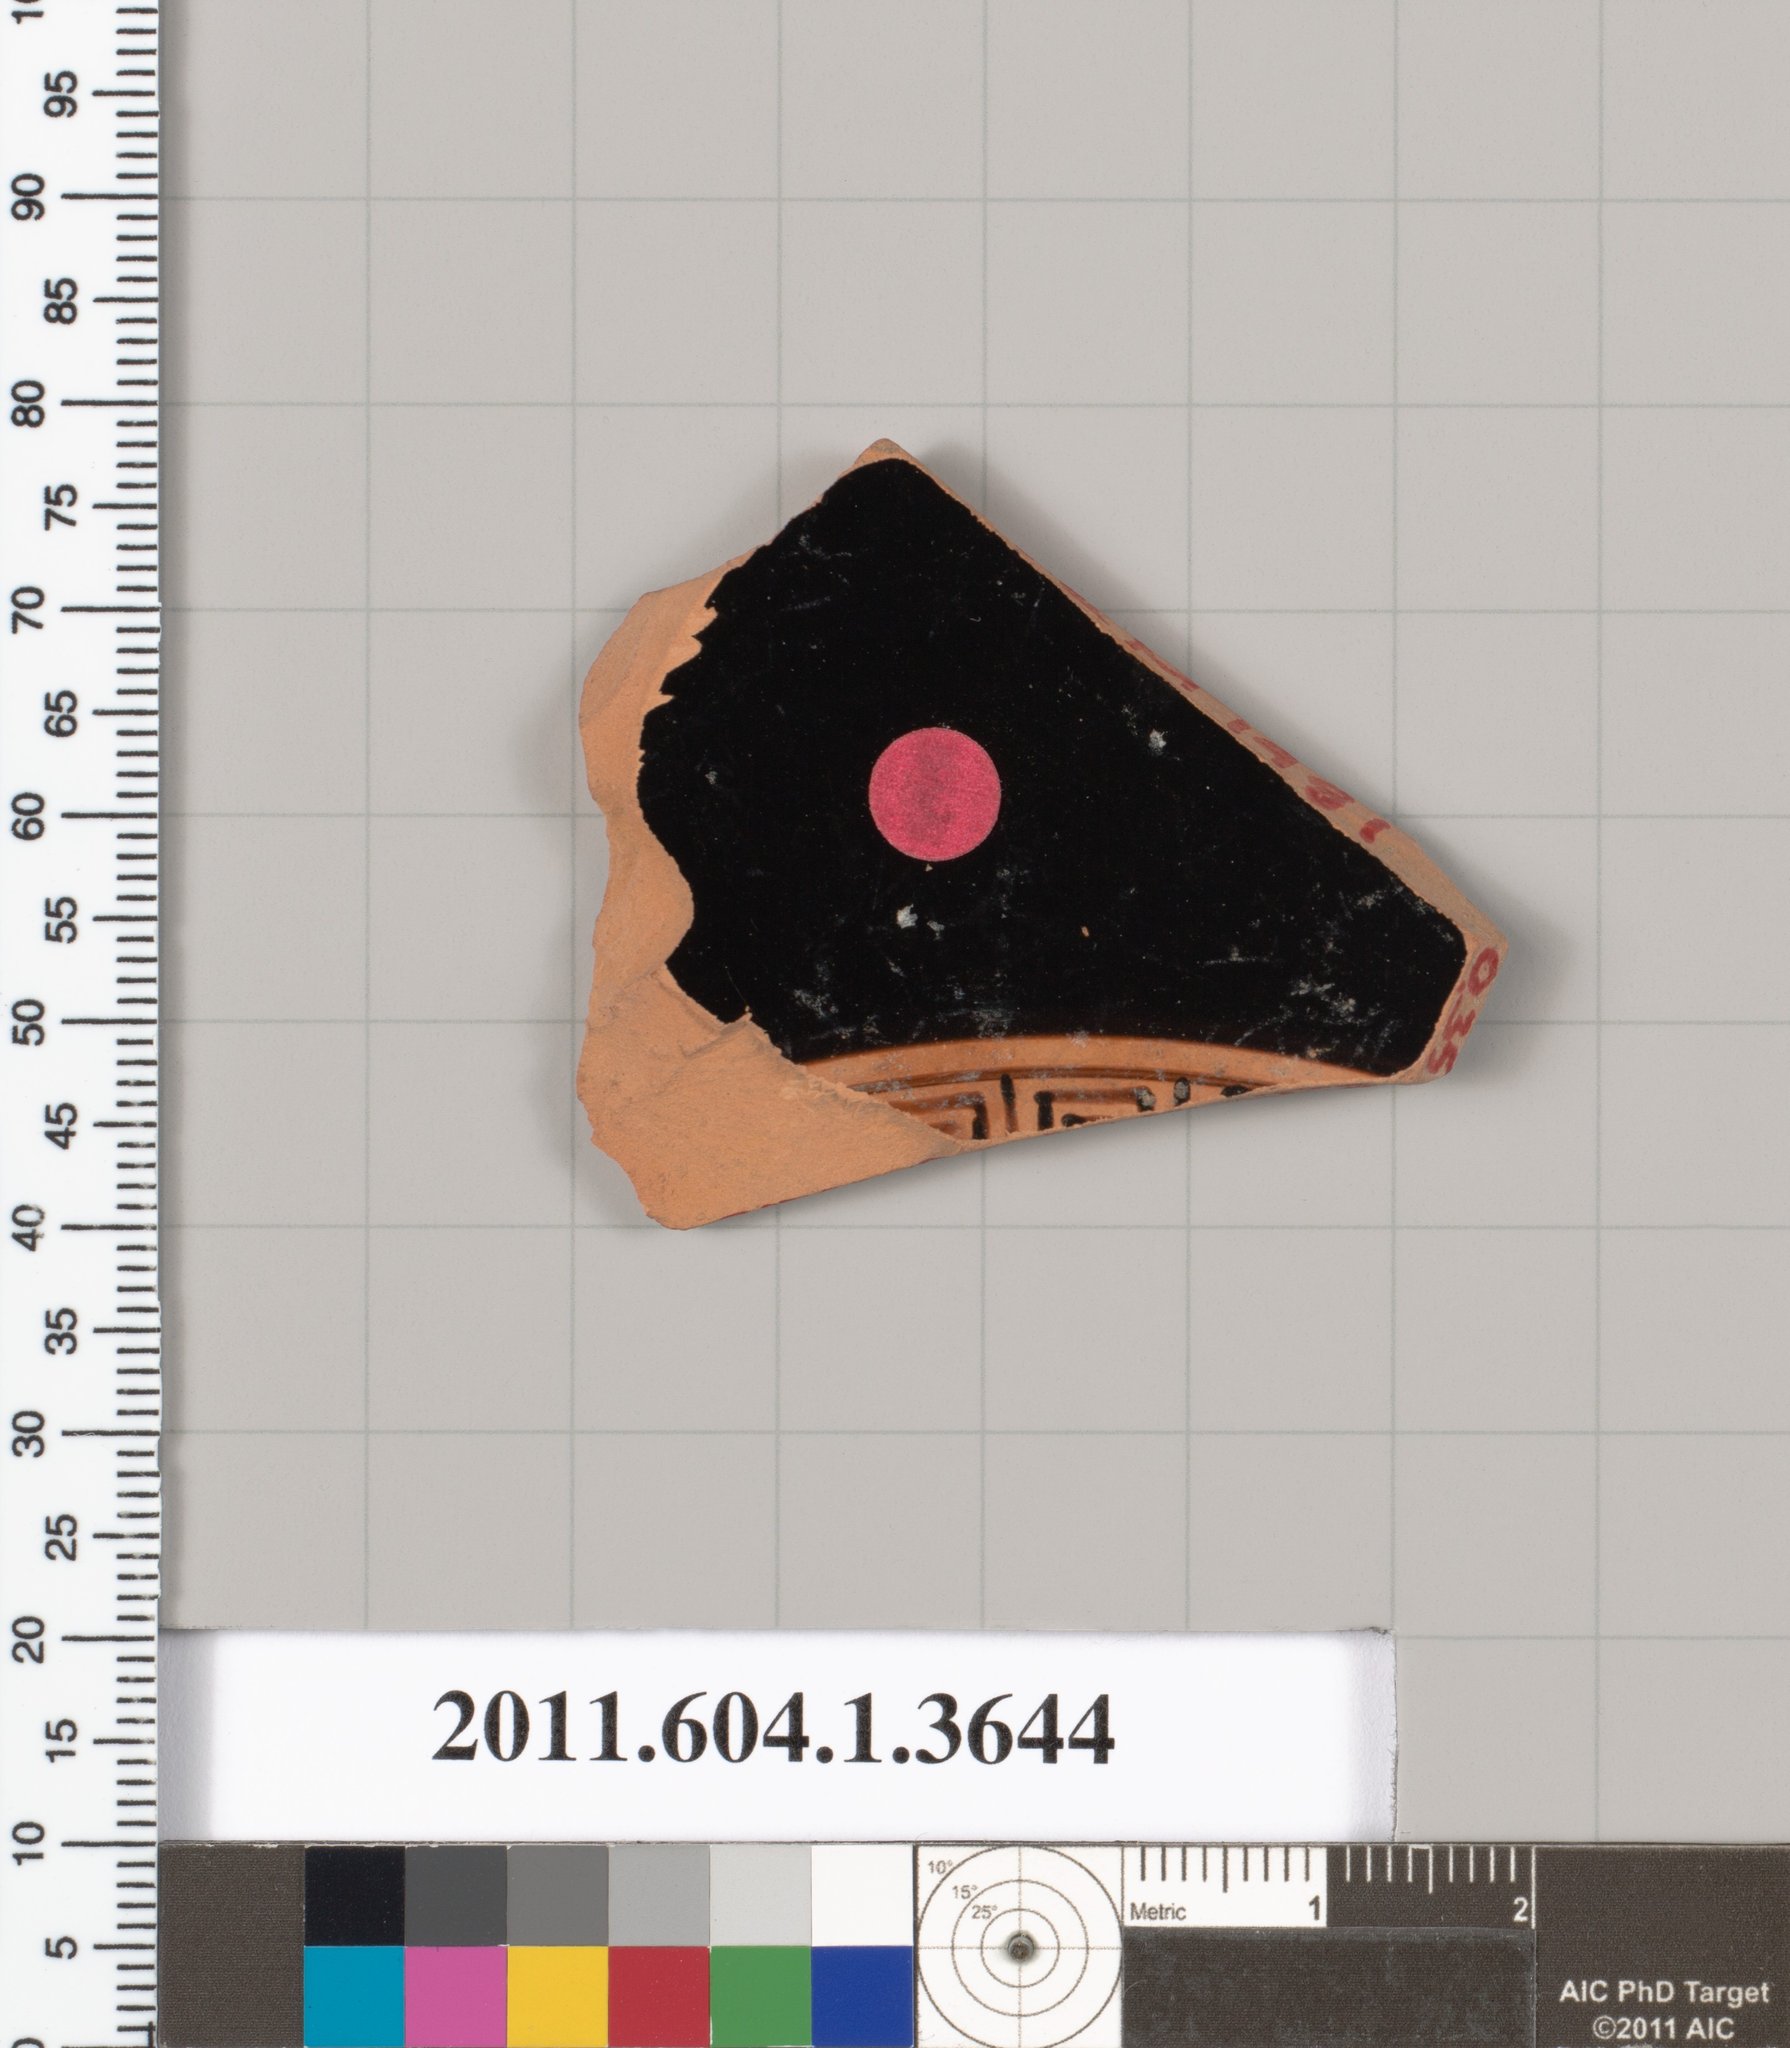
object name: kylix fragment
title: Terracotta fragment of a kylix (drinking cup)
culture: greek, attic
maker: douris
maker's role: artist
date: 490-470 BCE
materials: terracotta